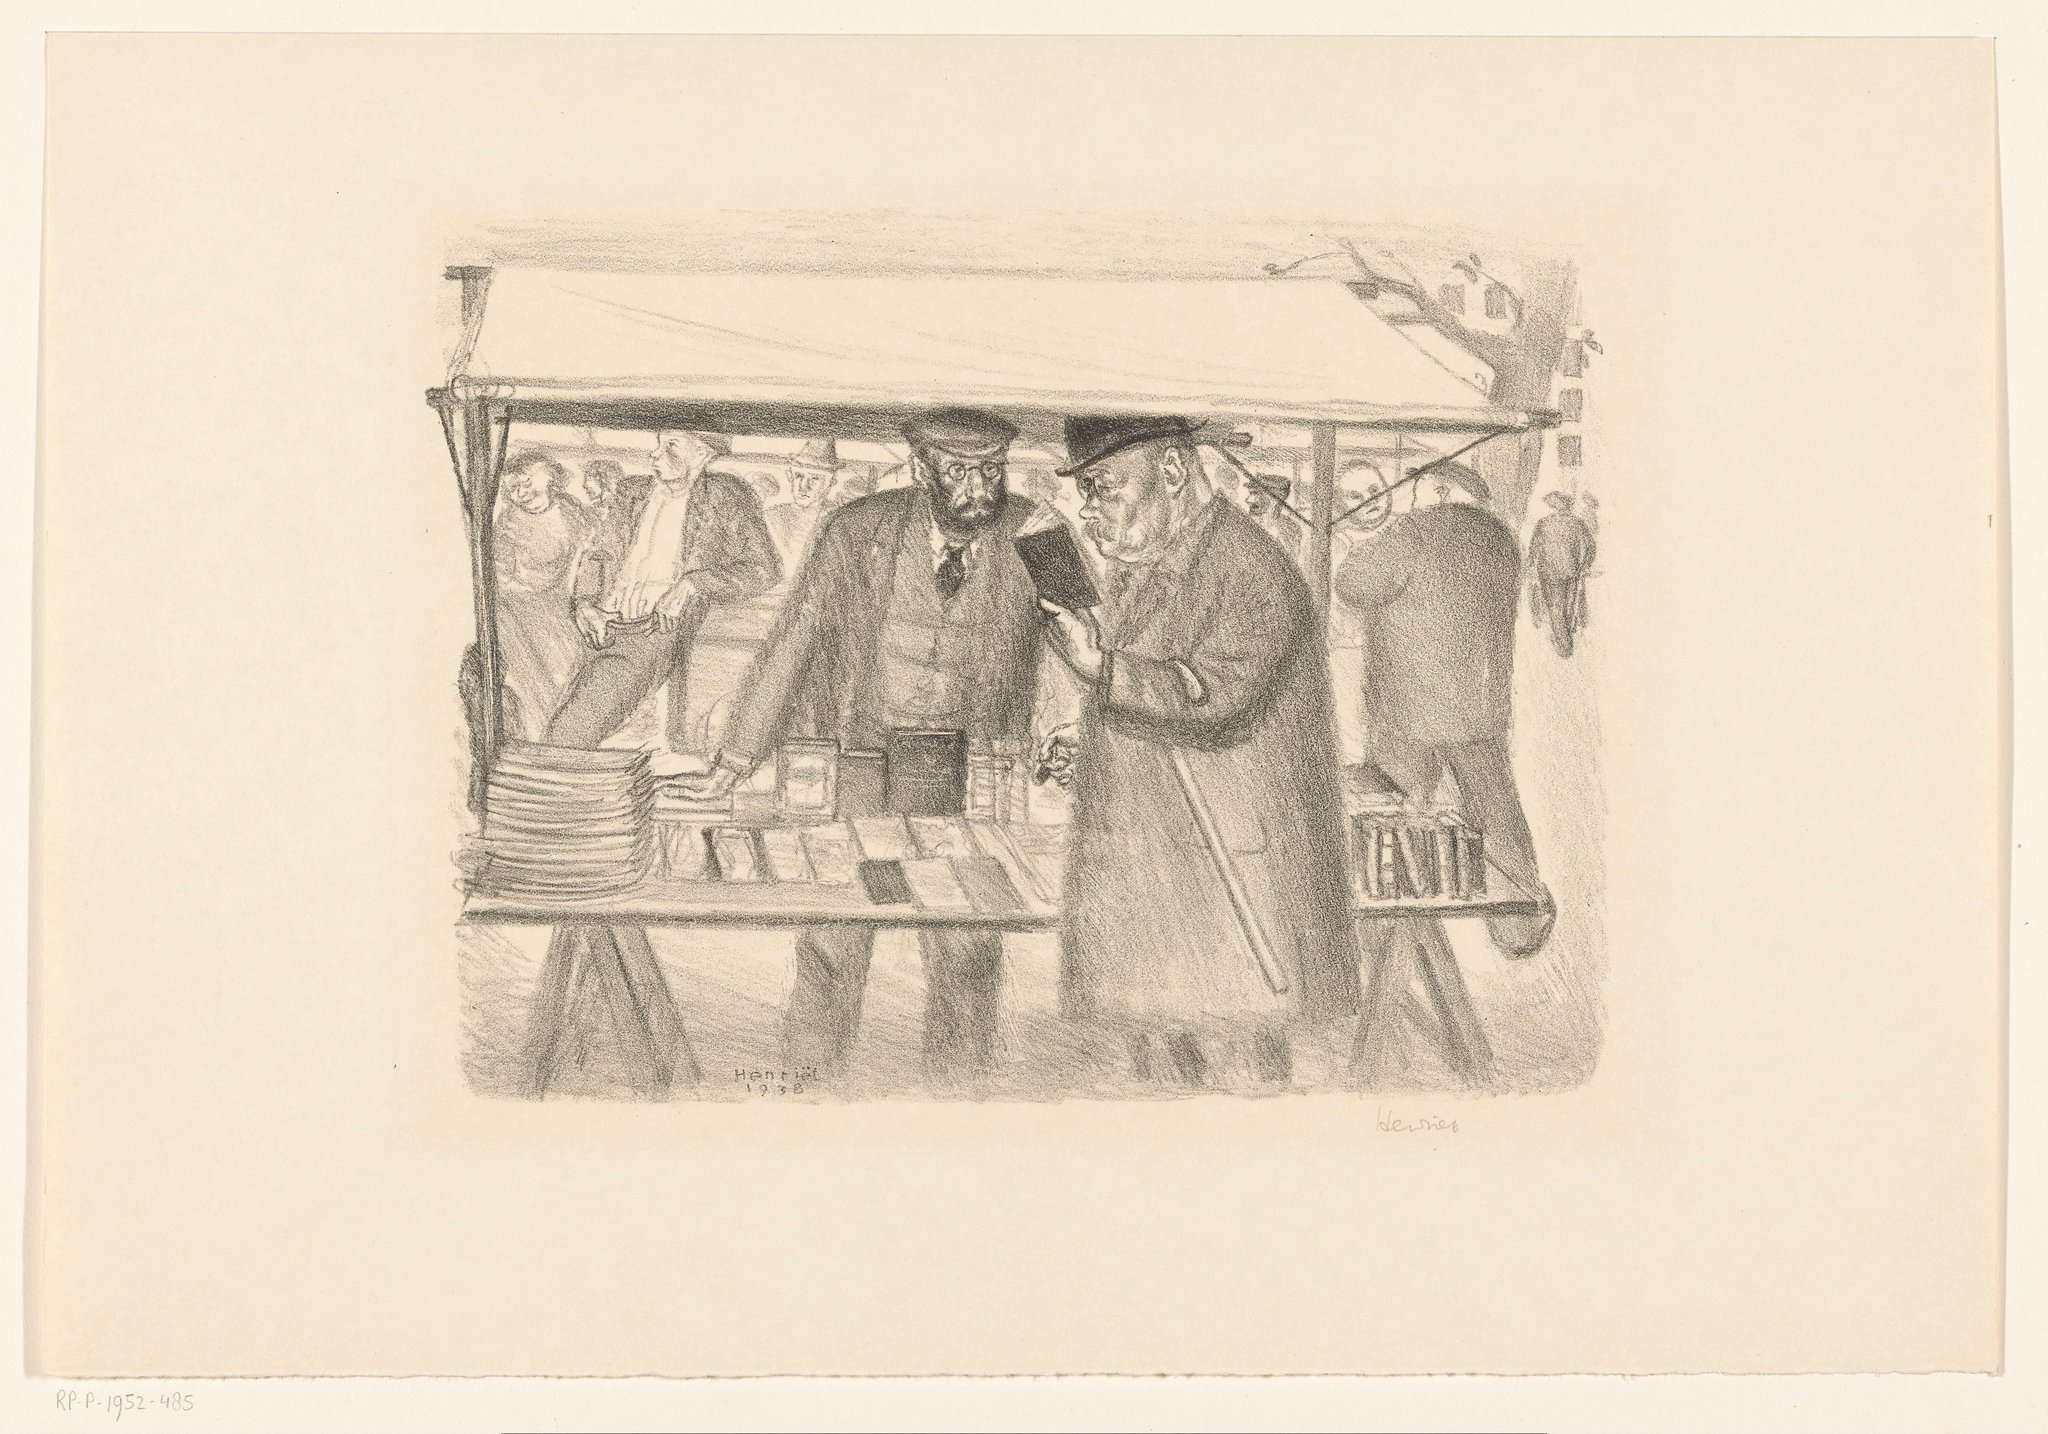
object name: print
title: Boekenstal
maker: henk henriët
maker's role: draughtsman, print maker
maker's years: 1903-1945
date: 1938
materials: paper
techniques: lithograph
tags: book-stall, kiosk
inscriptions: collector's mark: Lugt 2228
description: Een man met een bolhoed, sigaar en wandelstok staat voor de boekenstal en leest in een boek. De verkoper leunt naar voren vanachter zijn kraam.